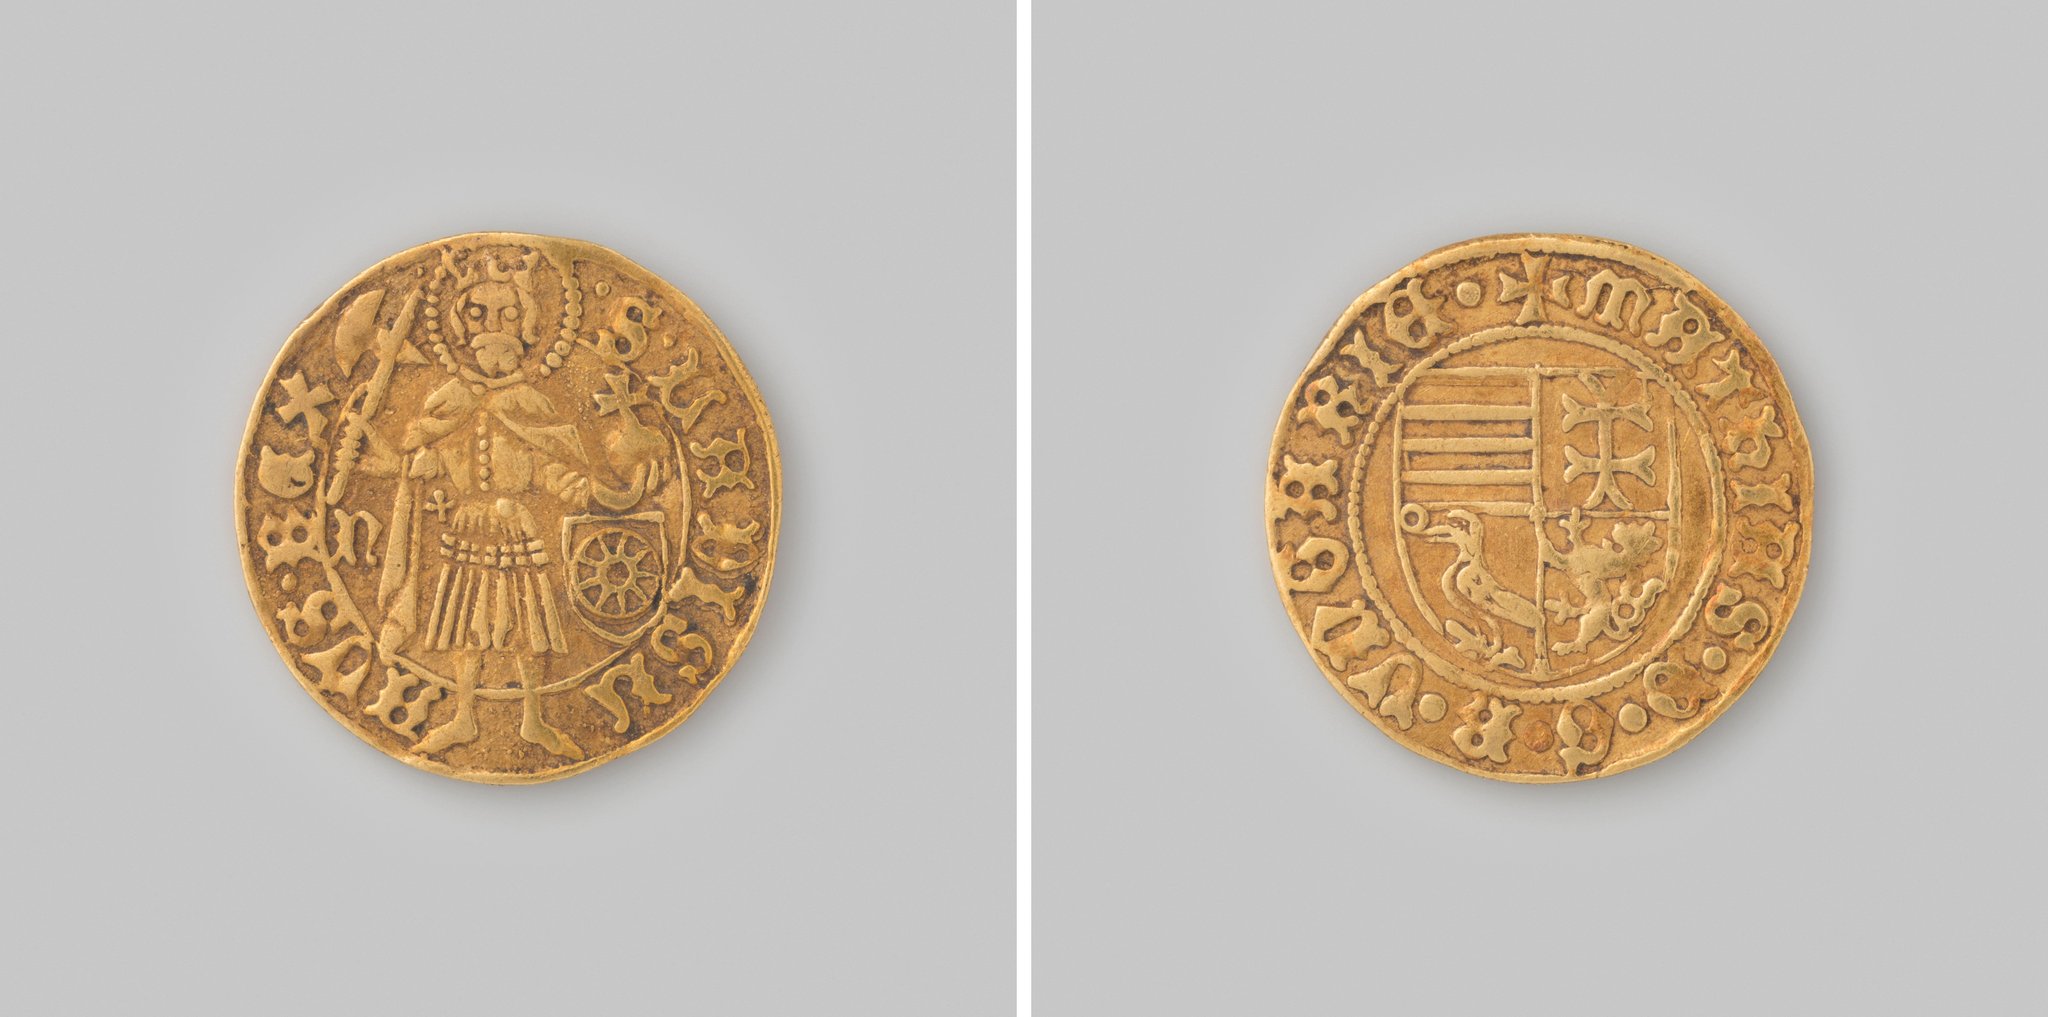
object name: ducat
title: Dukaat uit Hongarije van koning Matthias Corvinus,1458-1490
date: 1458-1490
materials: gold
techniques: striking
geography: kremnica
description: Gouden munt. Voorzijde: tussen munttekens letter N en rad in wapenschild heilige Stanislaus, staande, met in zijn linkerhand een rijksappel en in zijn rechterhand een bijl. Keerzijde: samengesteld wapenschild.